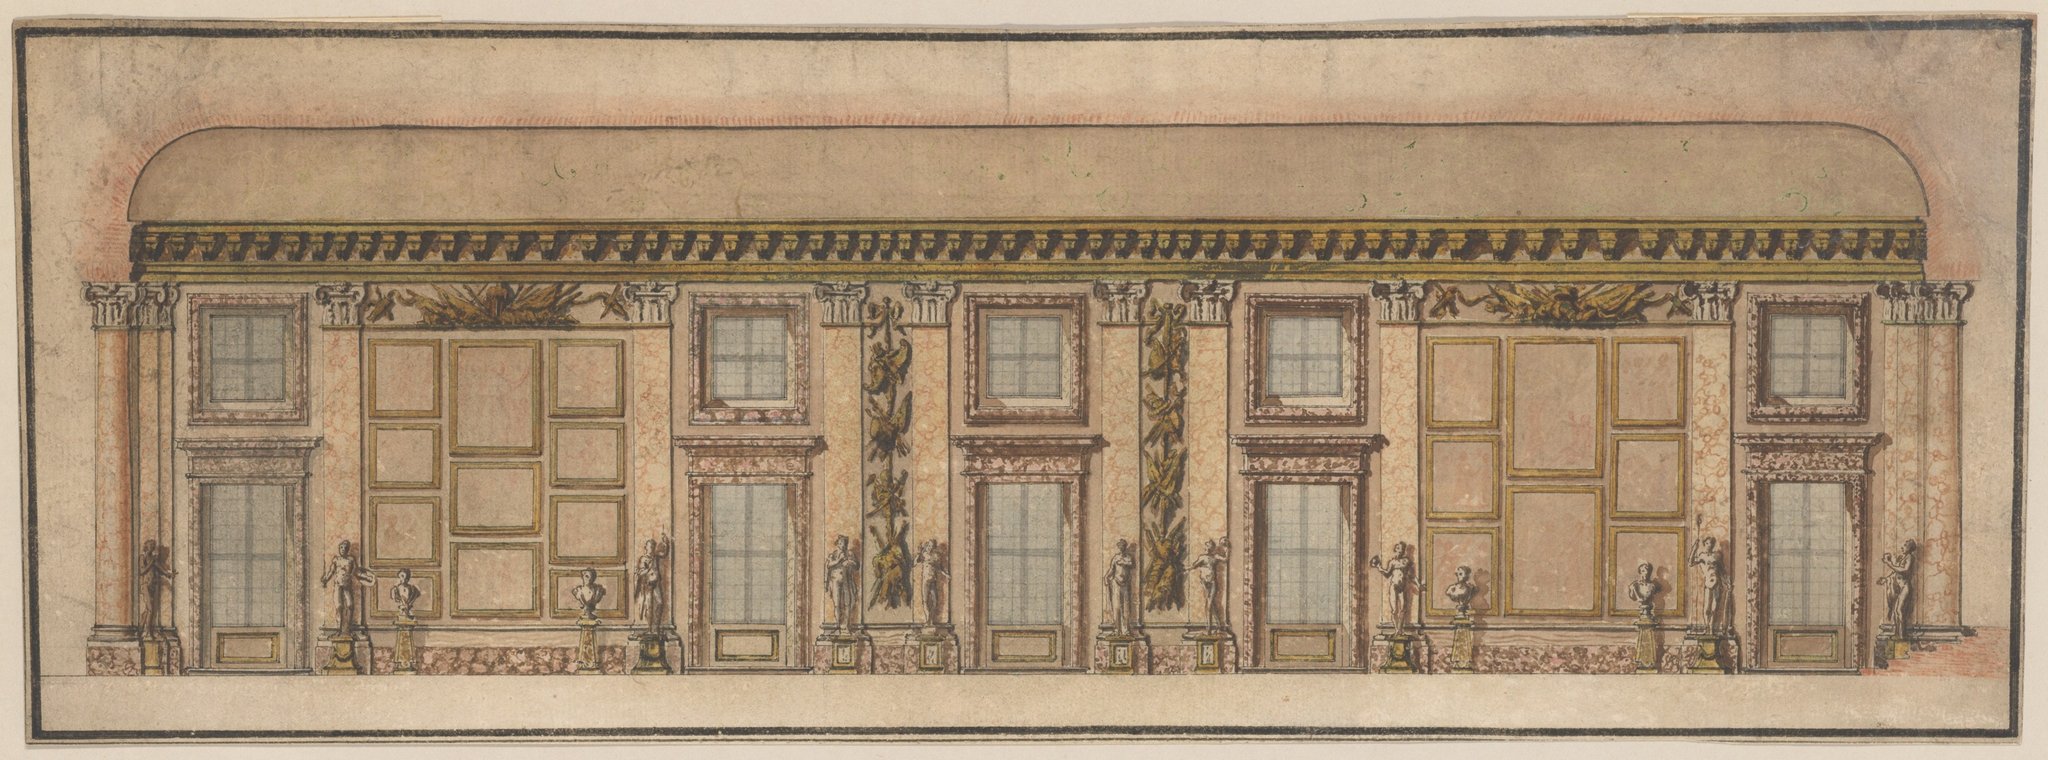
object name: drawing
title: Elevation of the Gallery in the Palazzo Doria-Pamphilj, Rome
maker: anonymous, italian, 17th century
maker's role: artist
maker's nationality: italian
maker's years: 1600-1700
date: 1650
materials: ink, watercolor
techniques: pen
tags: architecture,interiors